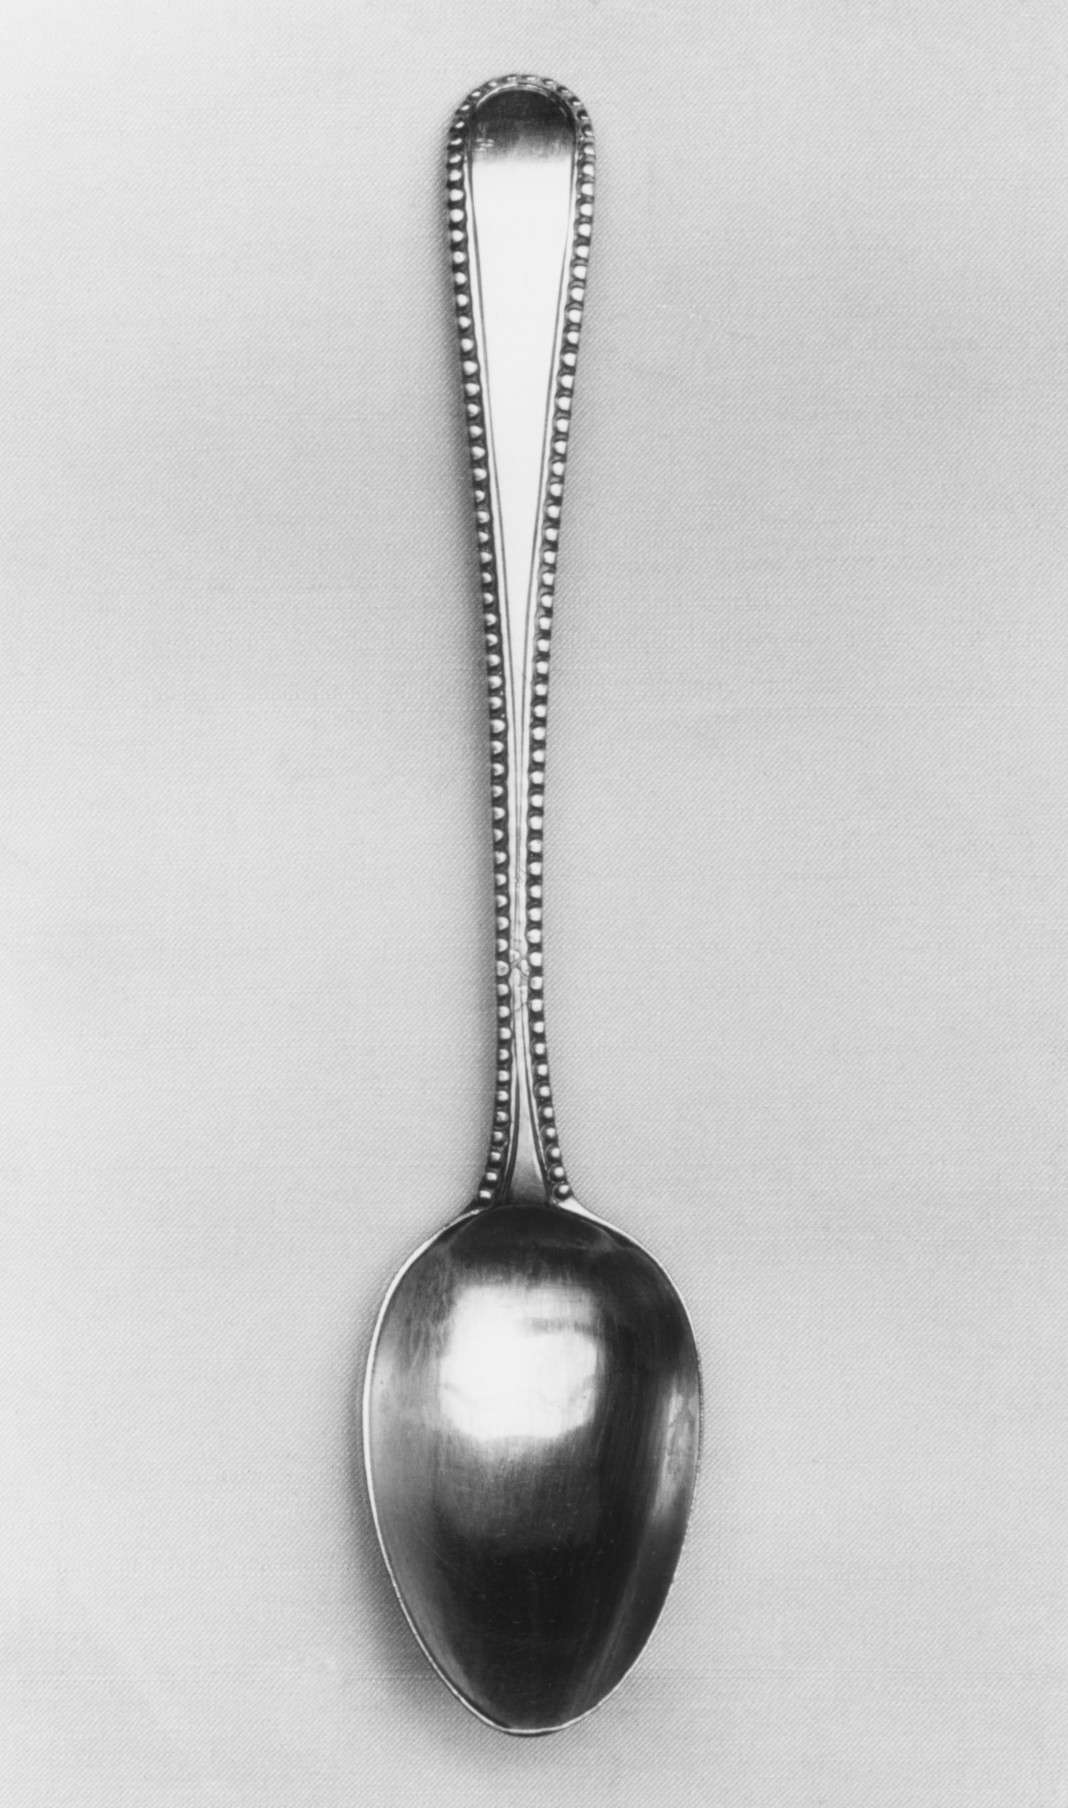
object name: coffee spoon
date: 1767-1833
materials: silver gilt